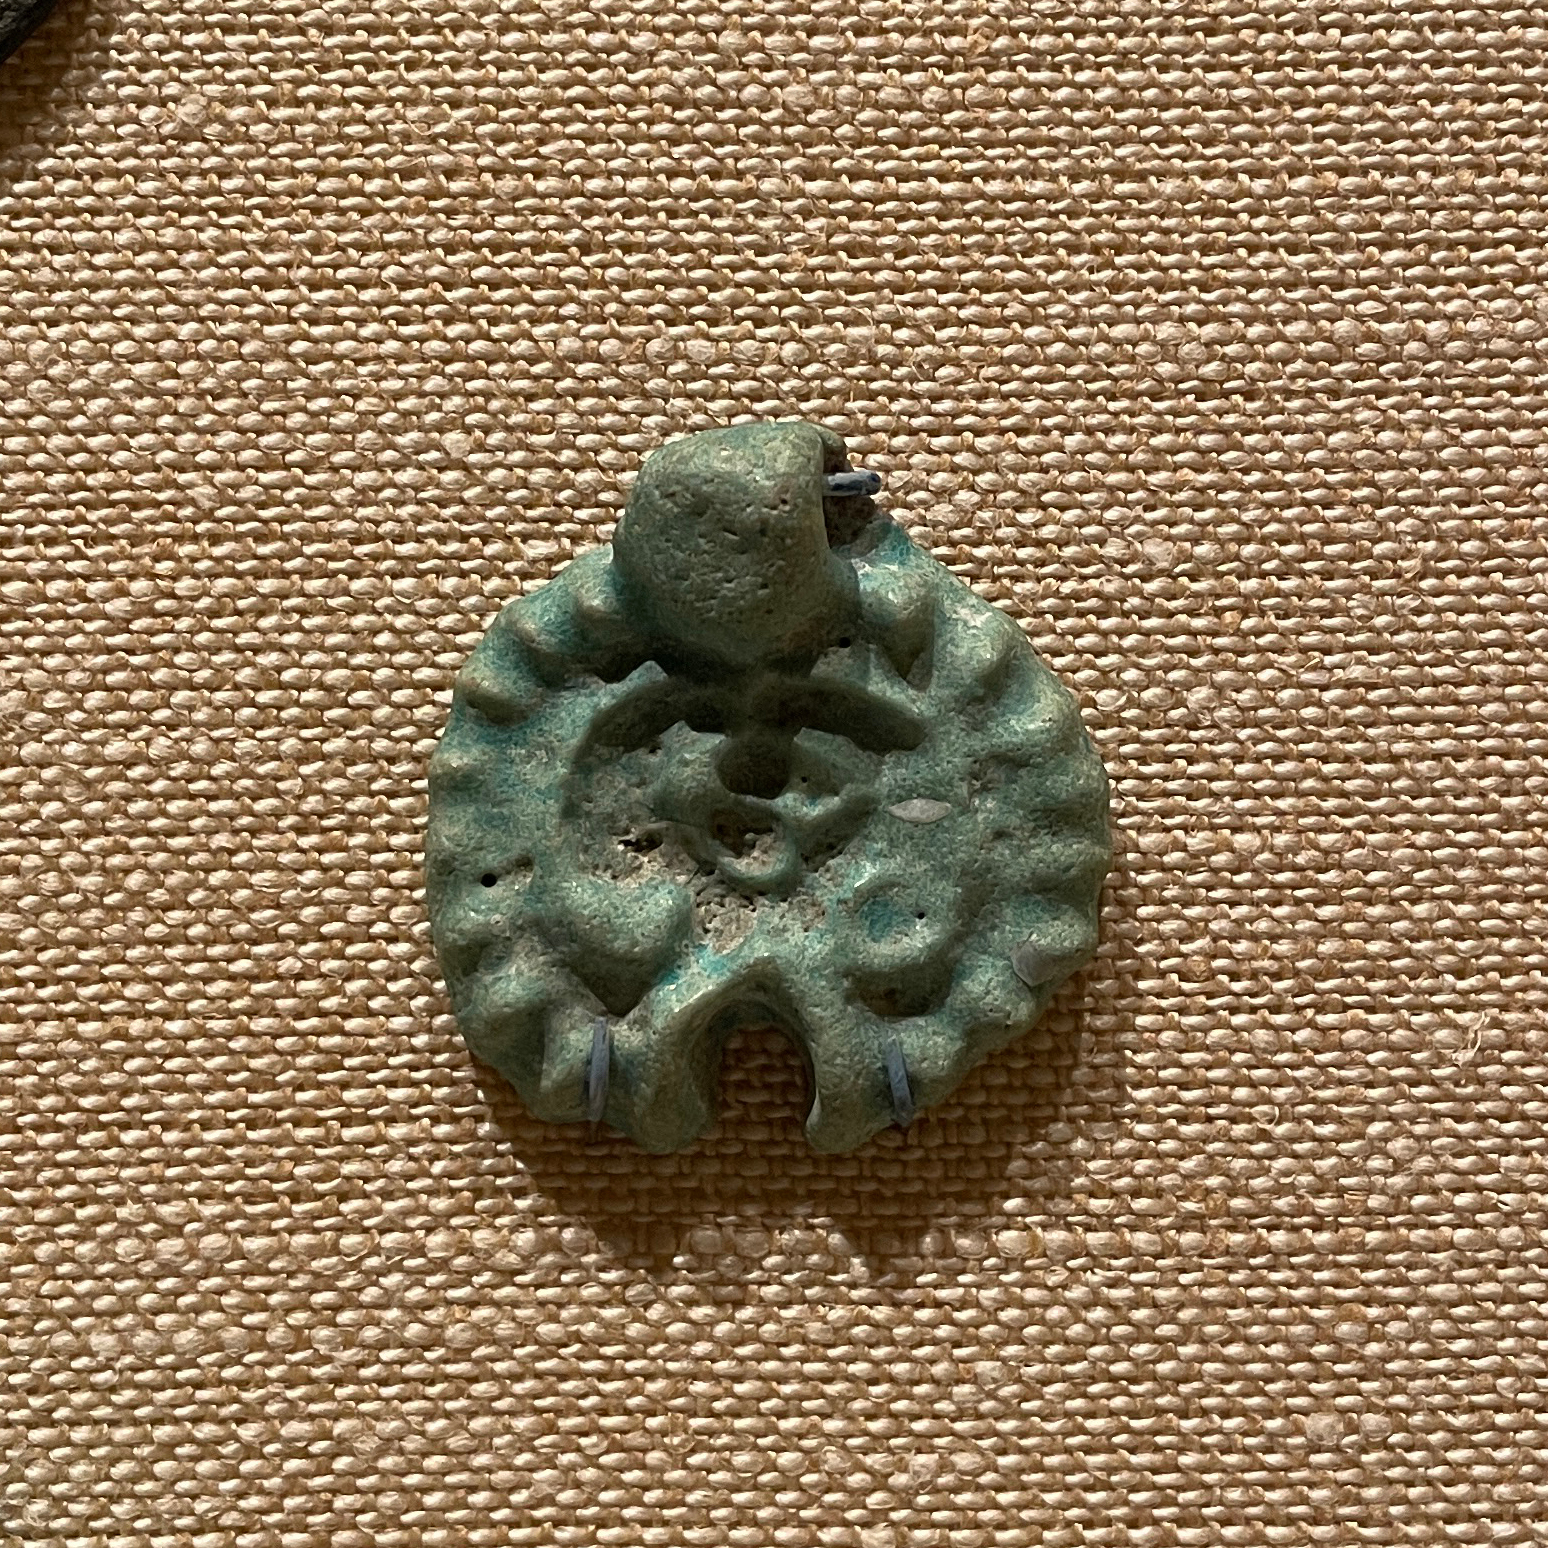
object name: pendant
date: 1001-1100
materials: earthenware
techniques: glazing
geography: iran